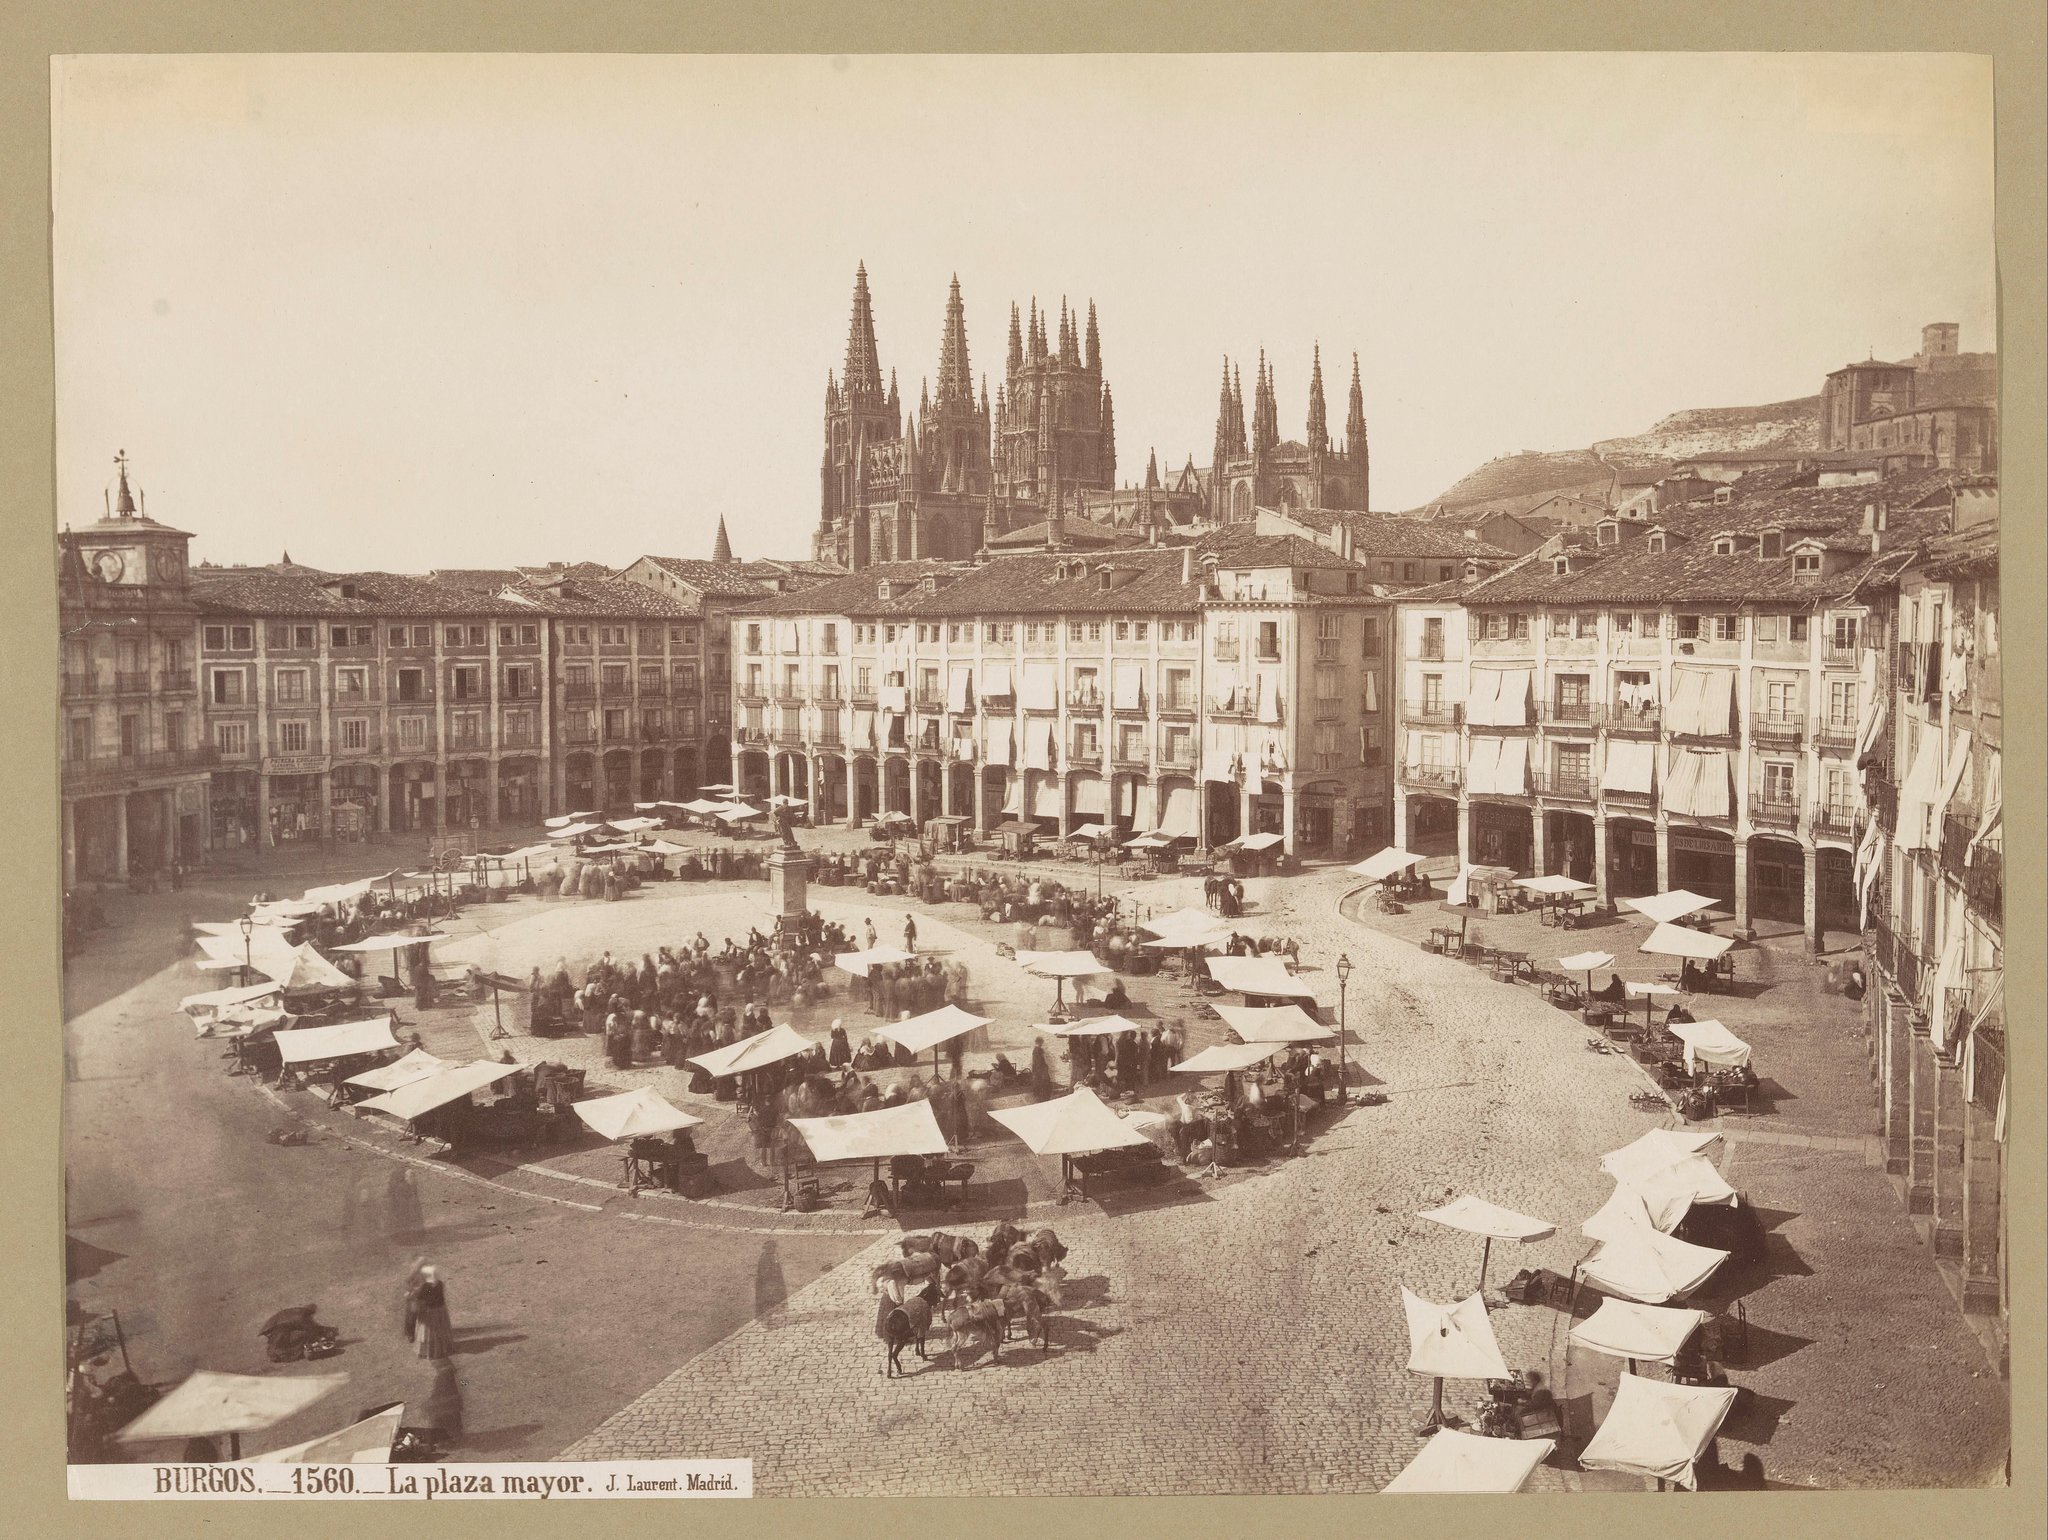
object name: photograph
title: Gezicht op een markt rondom het standbeeld van Karel III van Spanje op het Plaza Mayor in Burgos, op de achtergrond de kathedraal van Burgos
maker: juan laurent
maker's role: publisher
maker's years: 1816-1896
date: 1856-1863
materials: paper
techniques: albumen print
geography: burgos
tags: market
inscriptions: number: ‘1560.’